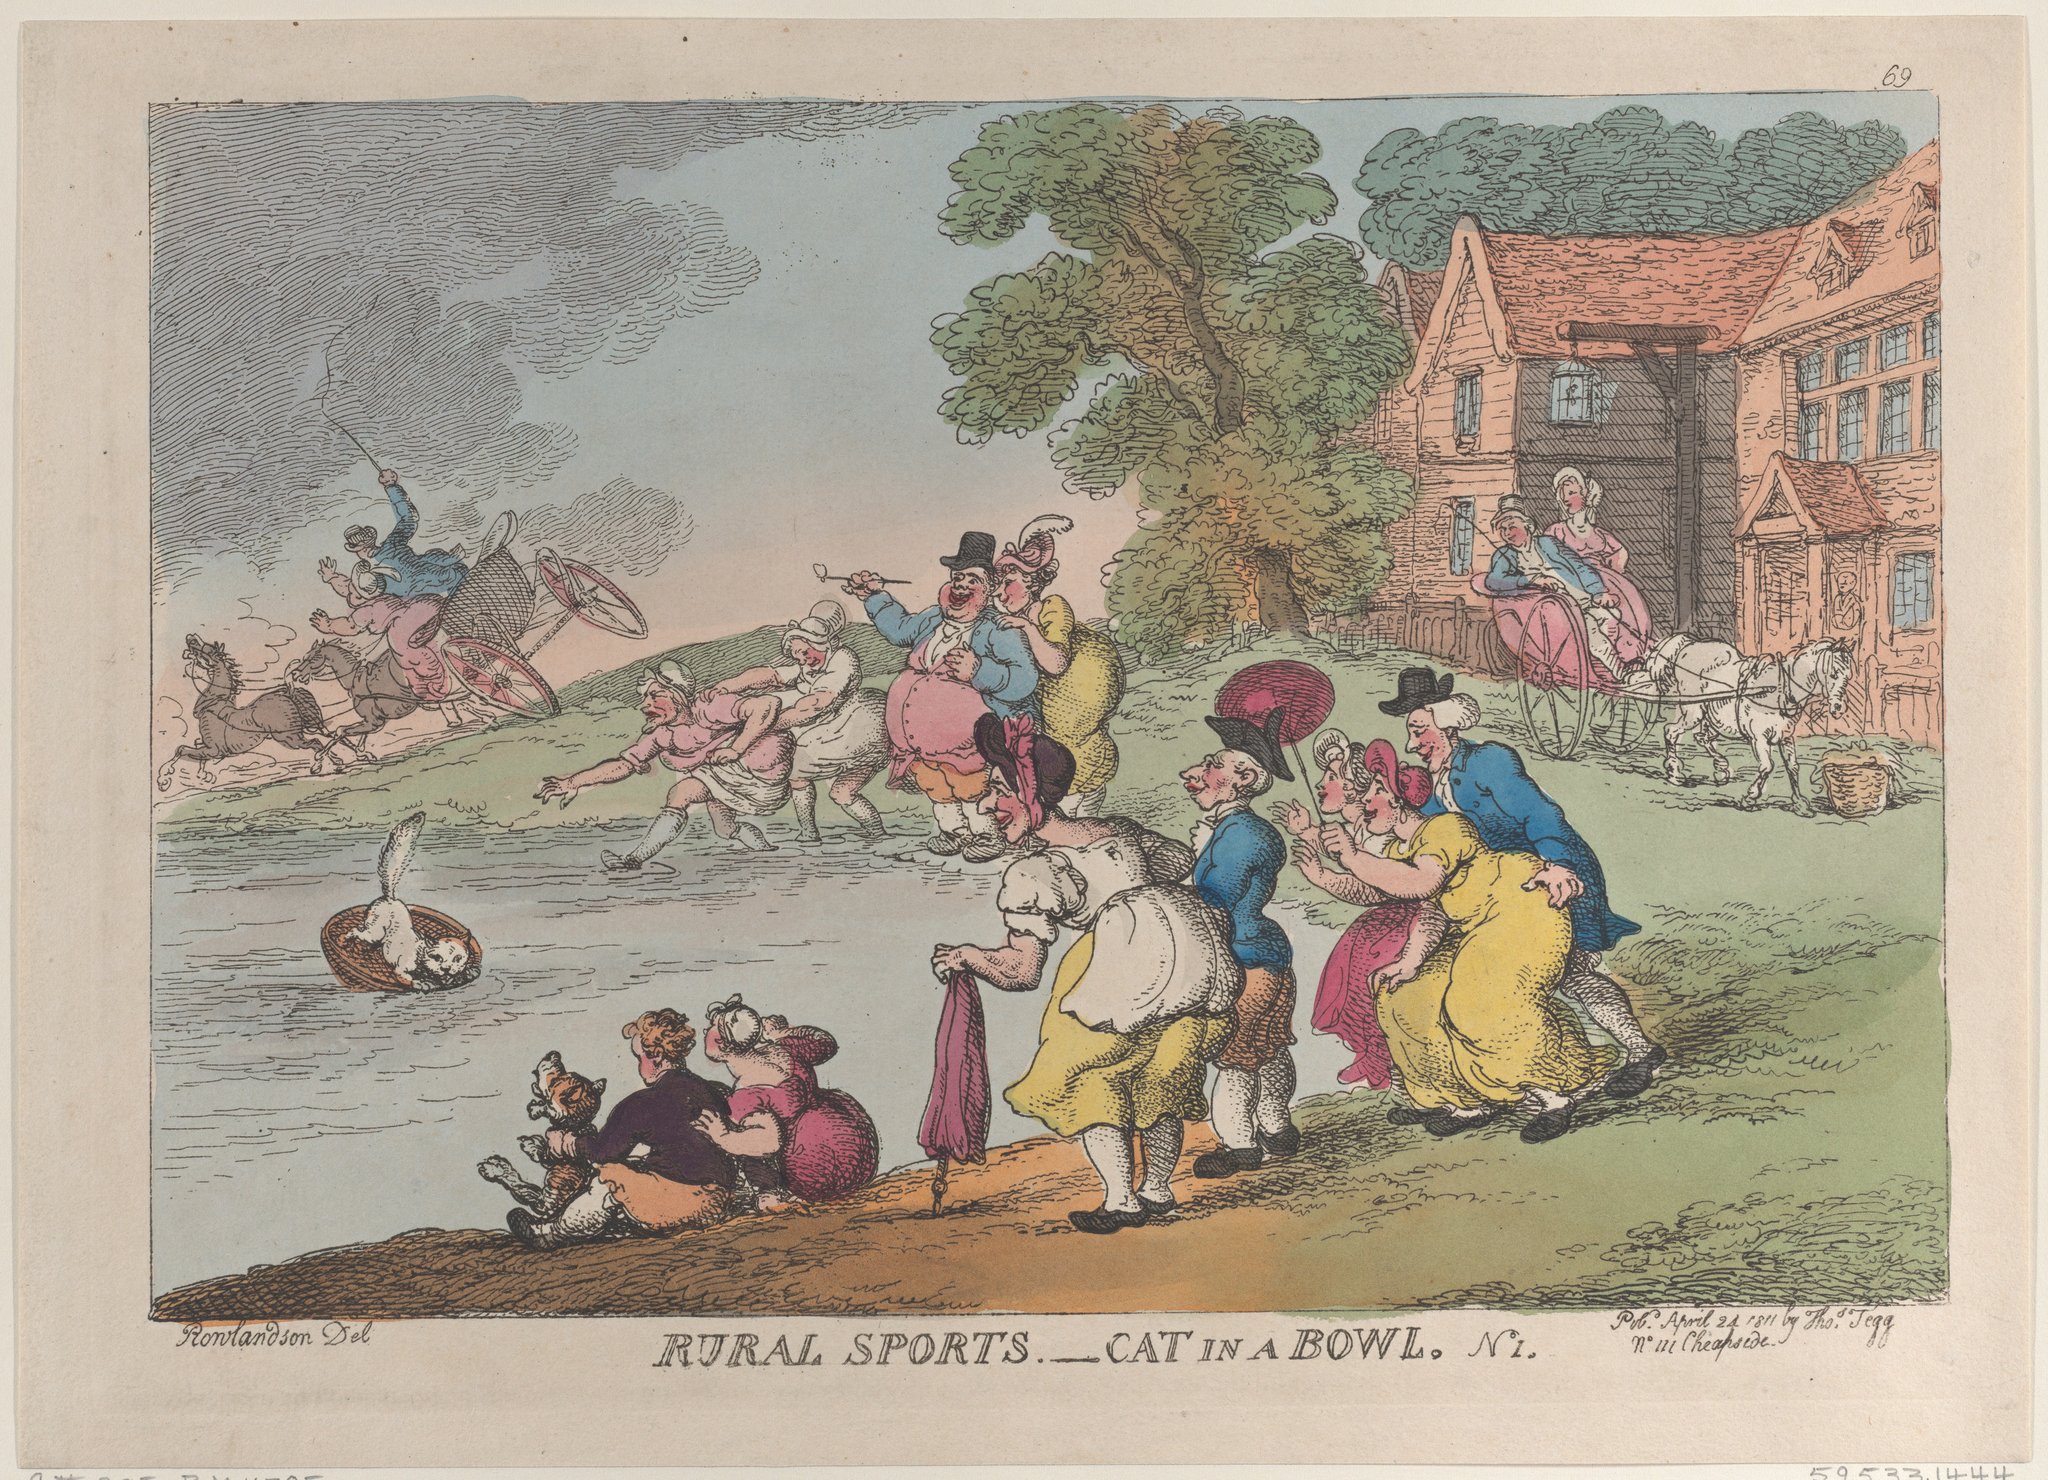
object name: print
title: Rural Sports: Cat in a Bowl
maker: thomas rowlandson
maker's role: artist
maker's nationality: british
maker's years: 1757-1827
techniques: etching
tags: satire,men,women,cats,carriages